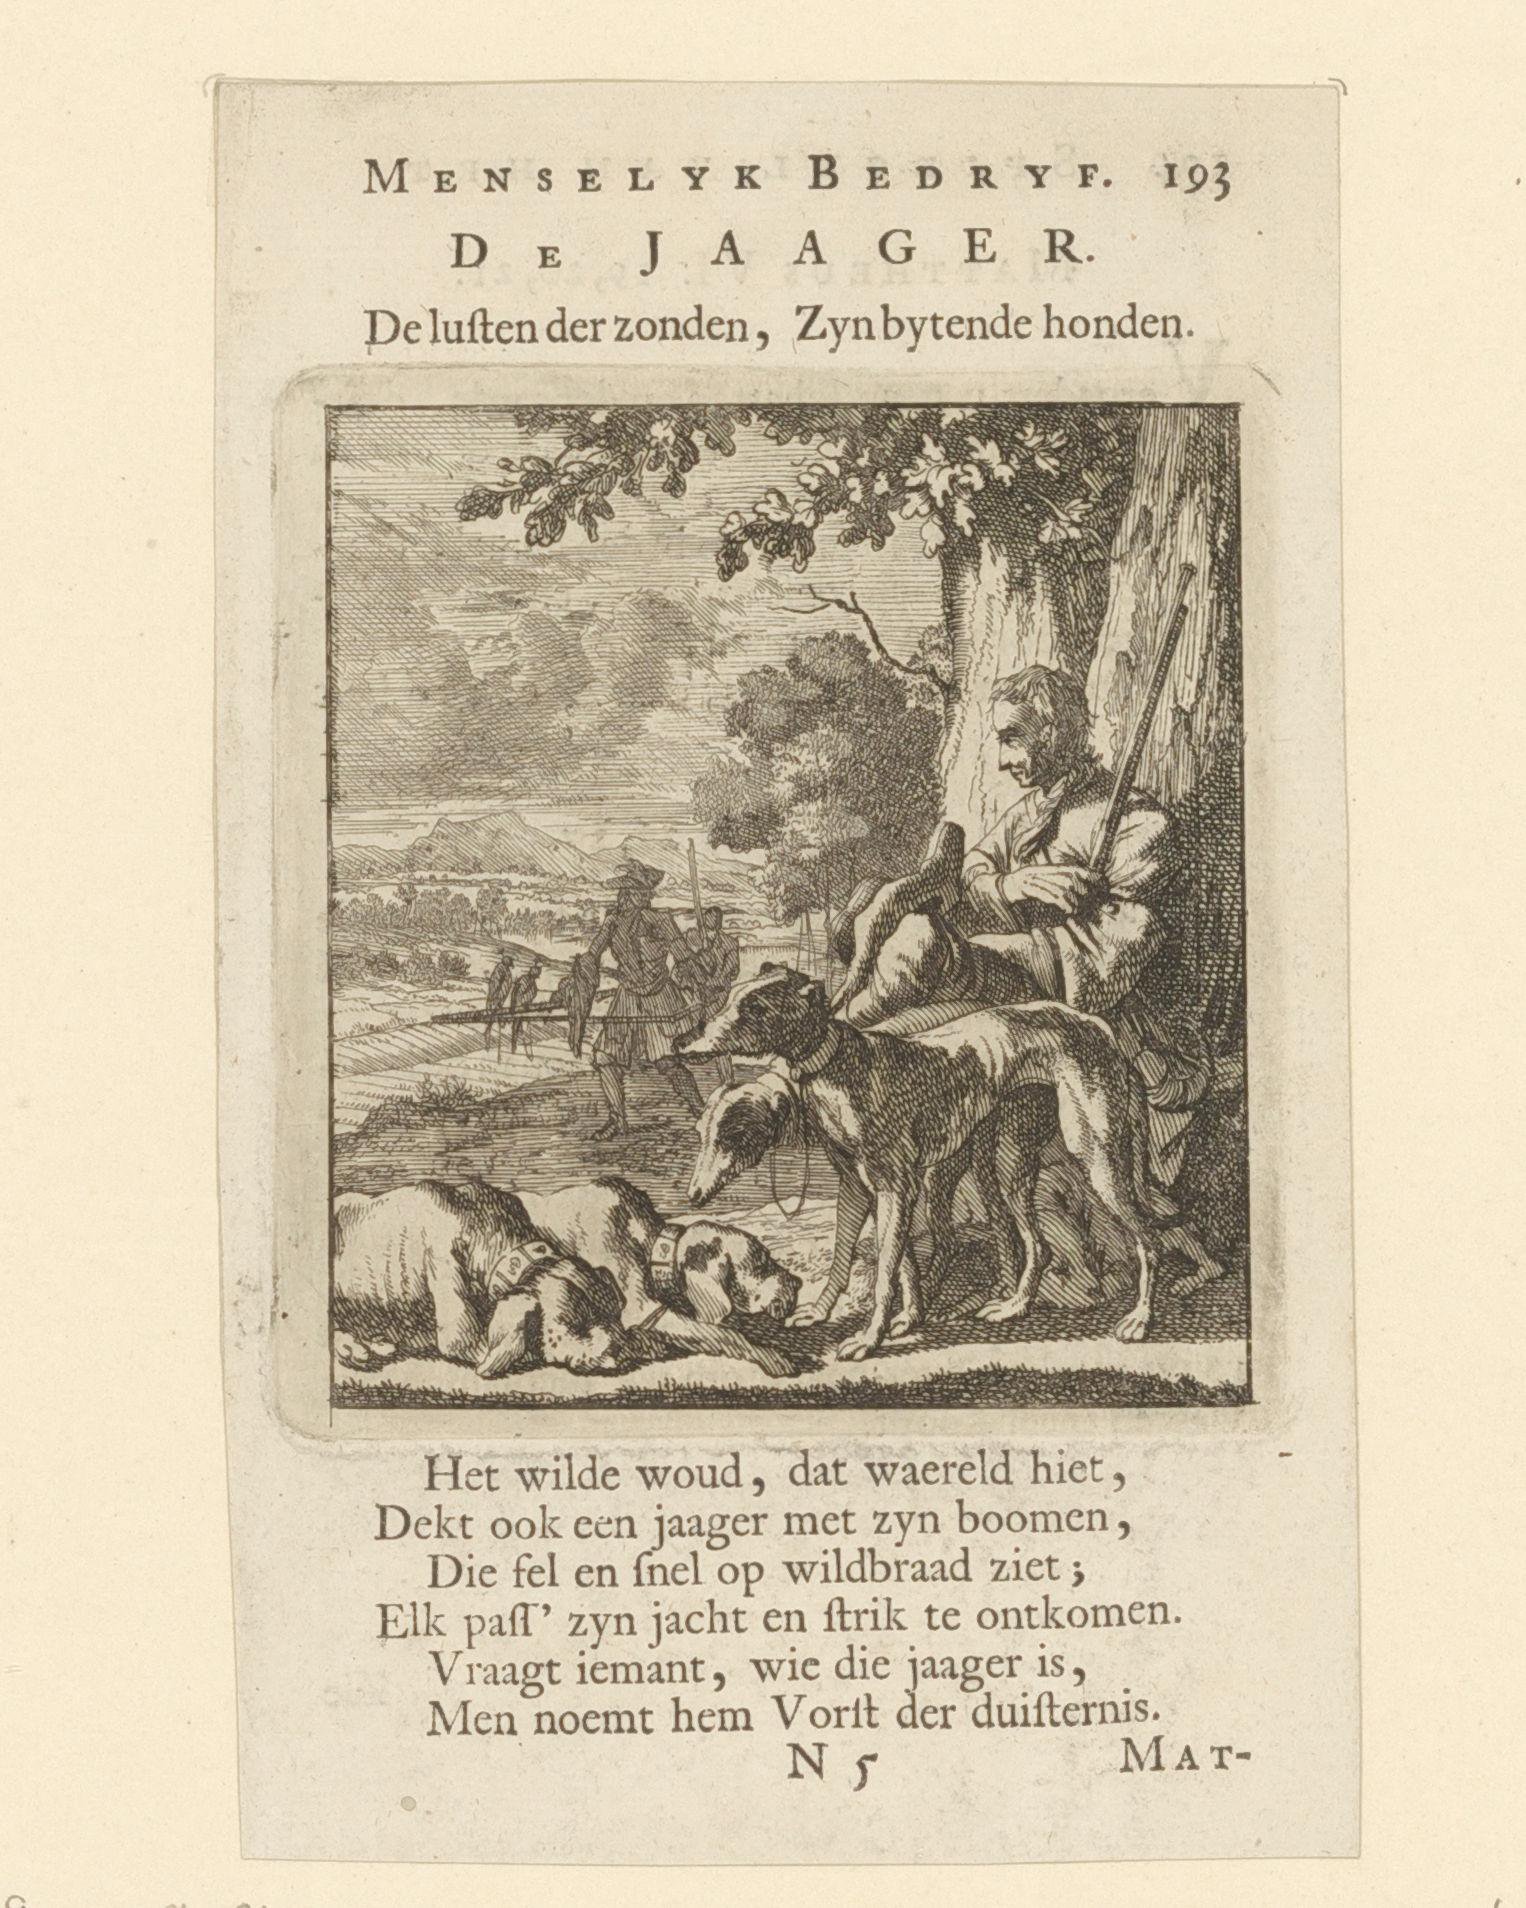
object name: print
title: Jager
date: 1718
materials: paper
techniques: etching, letterpress printing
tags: hunter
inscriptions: stamp, collector's mark: Lugt 1641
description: Prent voor het eerst verschenen in de 100-delige serie beroepsprenten van Jan en Caspar Luyken, getiteld: Het menselyk bedryf. S.l.s.n., 1694 (eerste druk). Huidige staat uit: Luyken, Jan en Caspar. Spiegel van het menselyk bedryf (...). Amsterdam: Cornelis van der Sys, 1718, p. 193.